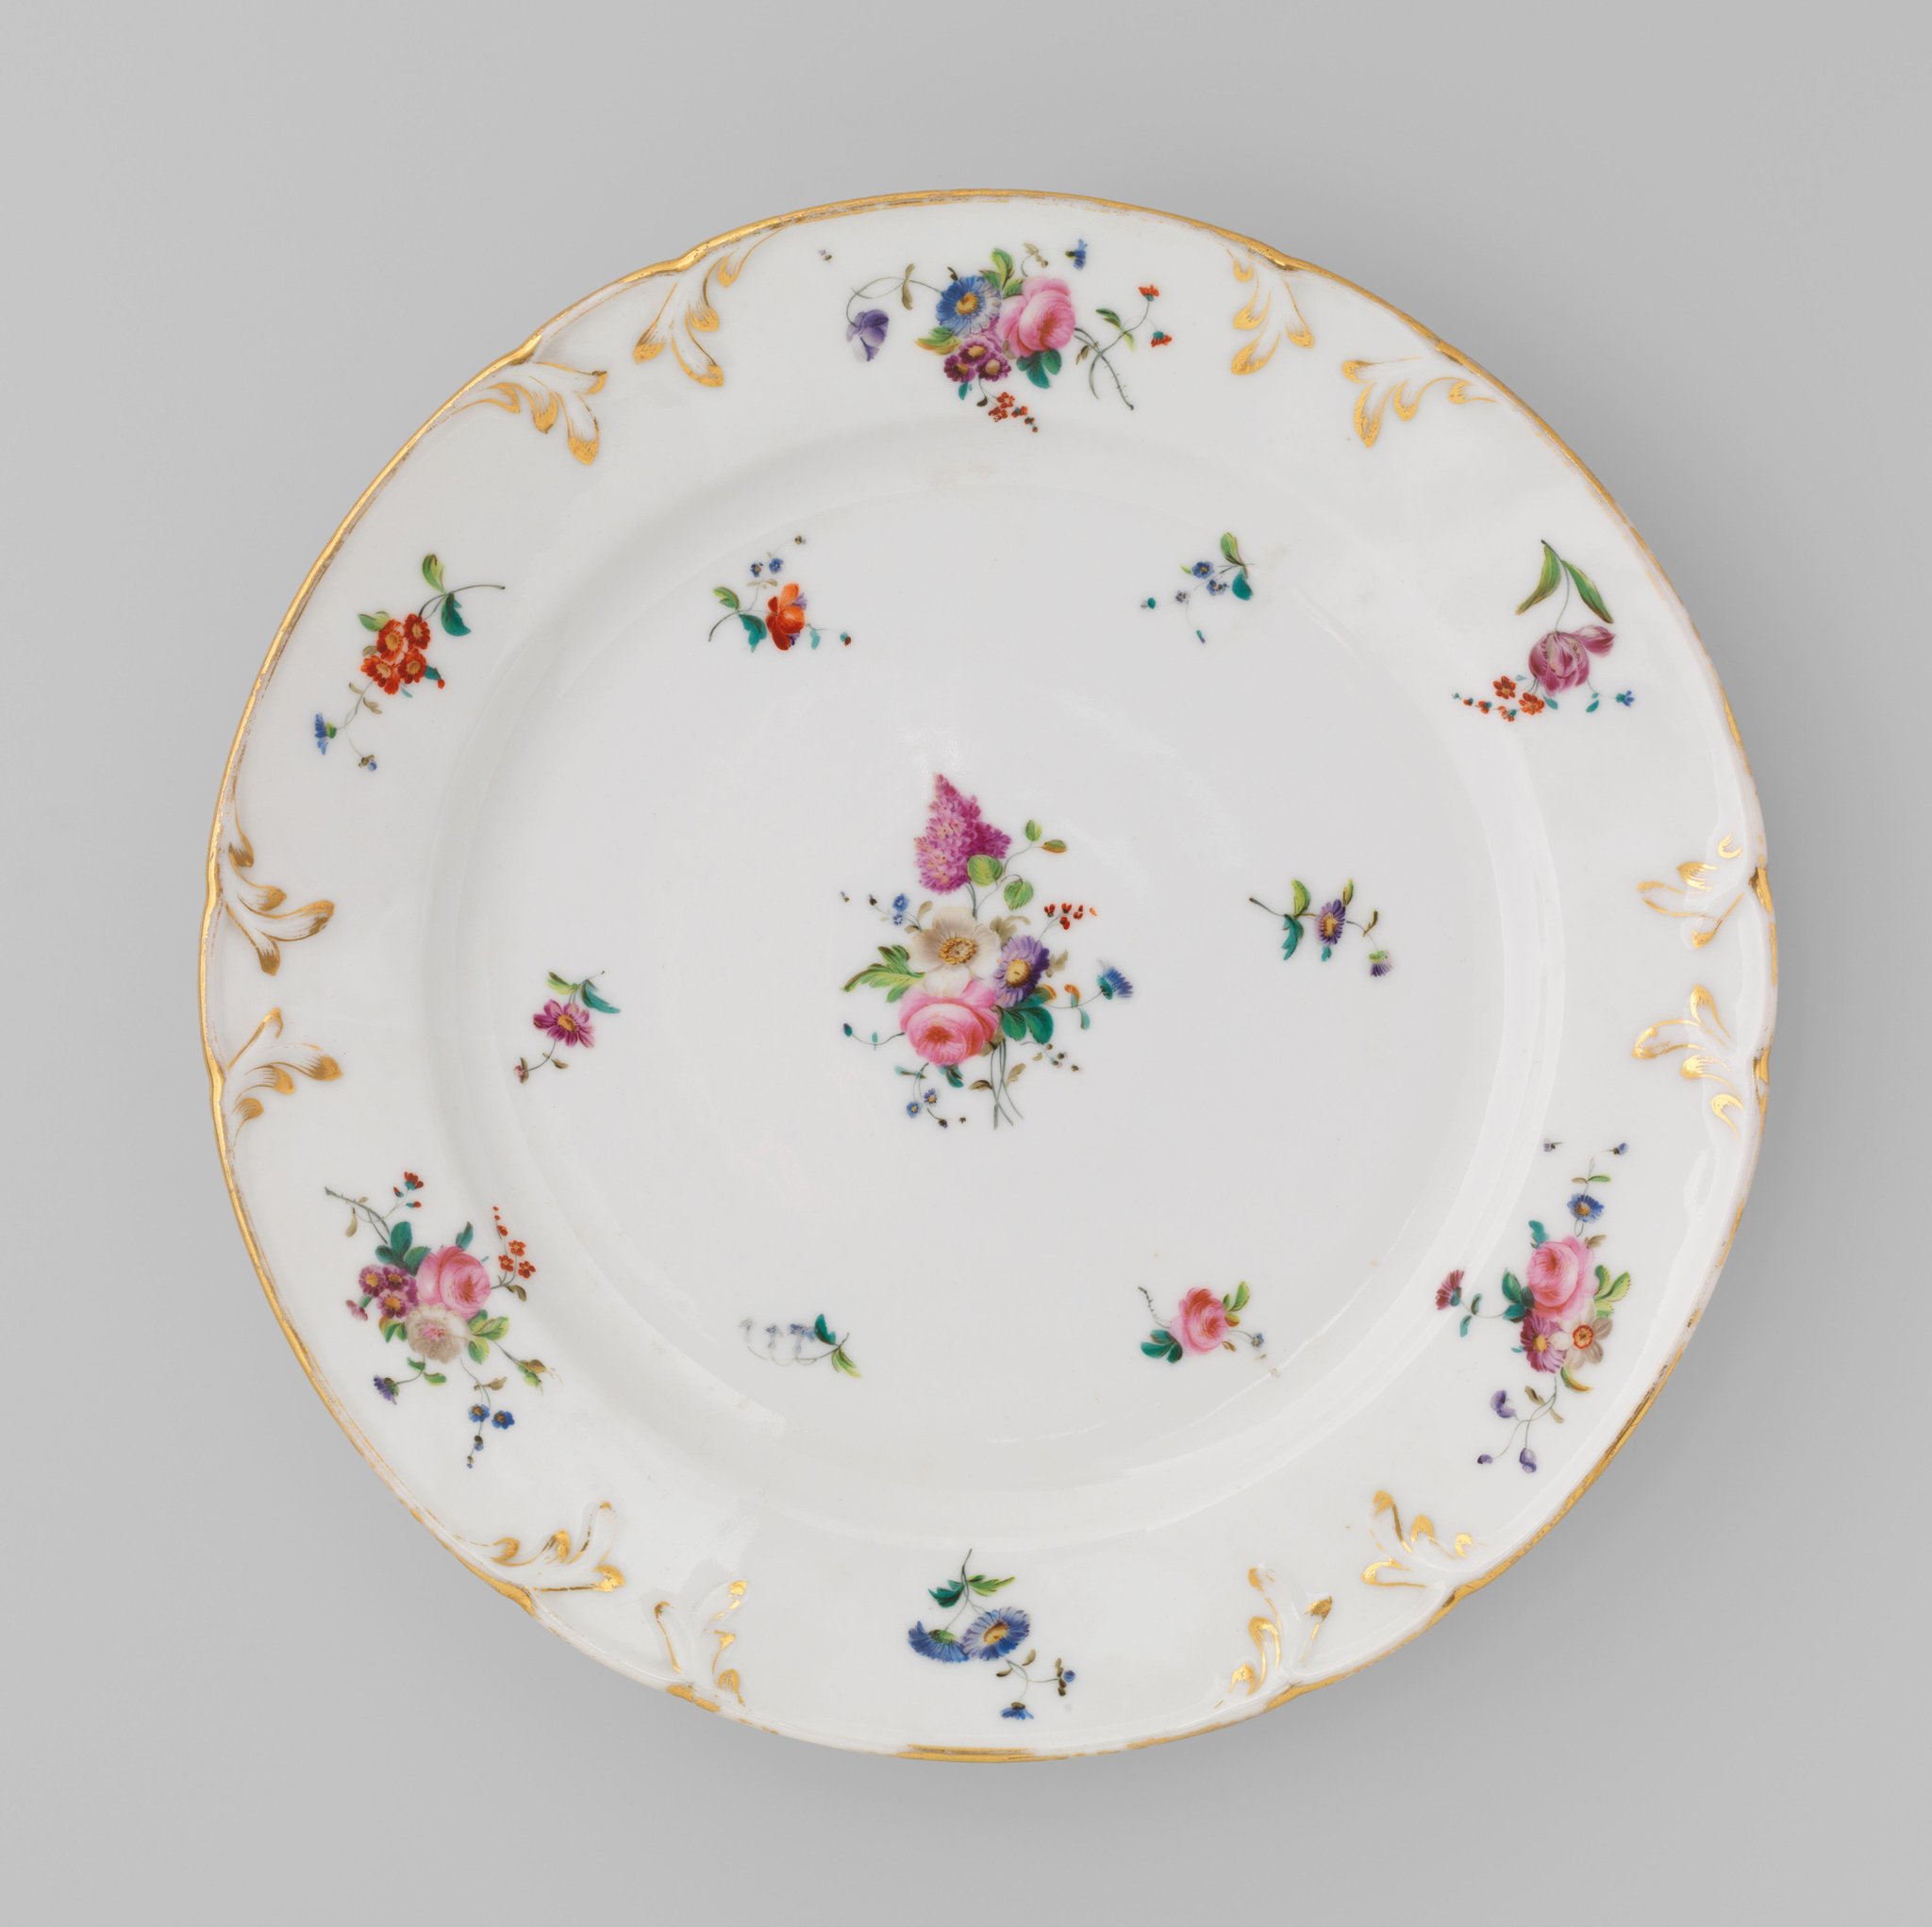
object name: service set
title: Dish with bouquets and flower sprays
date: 1839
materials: glaze, gold, paint, porcelain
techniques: firing, forming, gilding, turning, vitrification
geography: paris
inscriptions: mark: ‘DENUELLE/ Boulevard St. Denis 18/ à Paris’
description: Schotel van porselein met een gelobde rand, beschilderd op het glazuur in blauw, rood, roze, groen, geel, paars, zwart en goud. Op het plat boeketten van verschillende bloemen en strooibloemen. Vanuit de gelobde, gouden rand, gemodelleerde bladranken in reliëf, aangezet met goud. Hiertussen boeketten. Dubbele voetring. Gemerkt op de onderzijde met 'DENUELLE/ Boulevard St. Denis 18/ à Paris'.